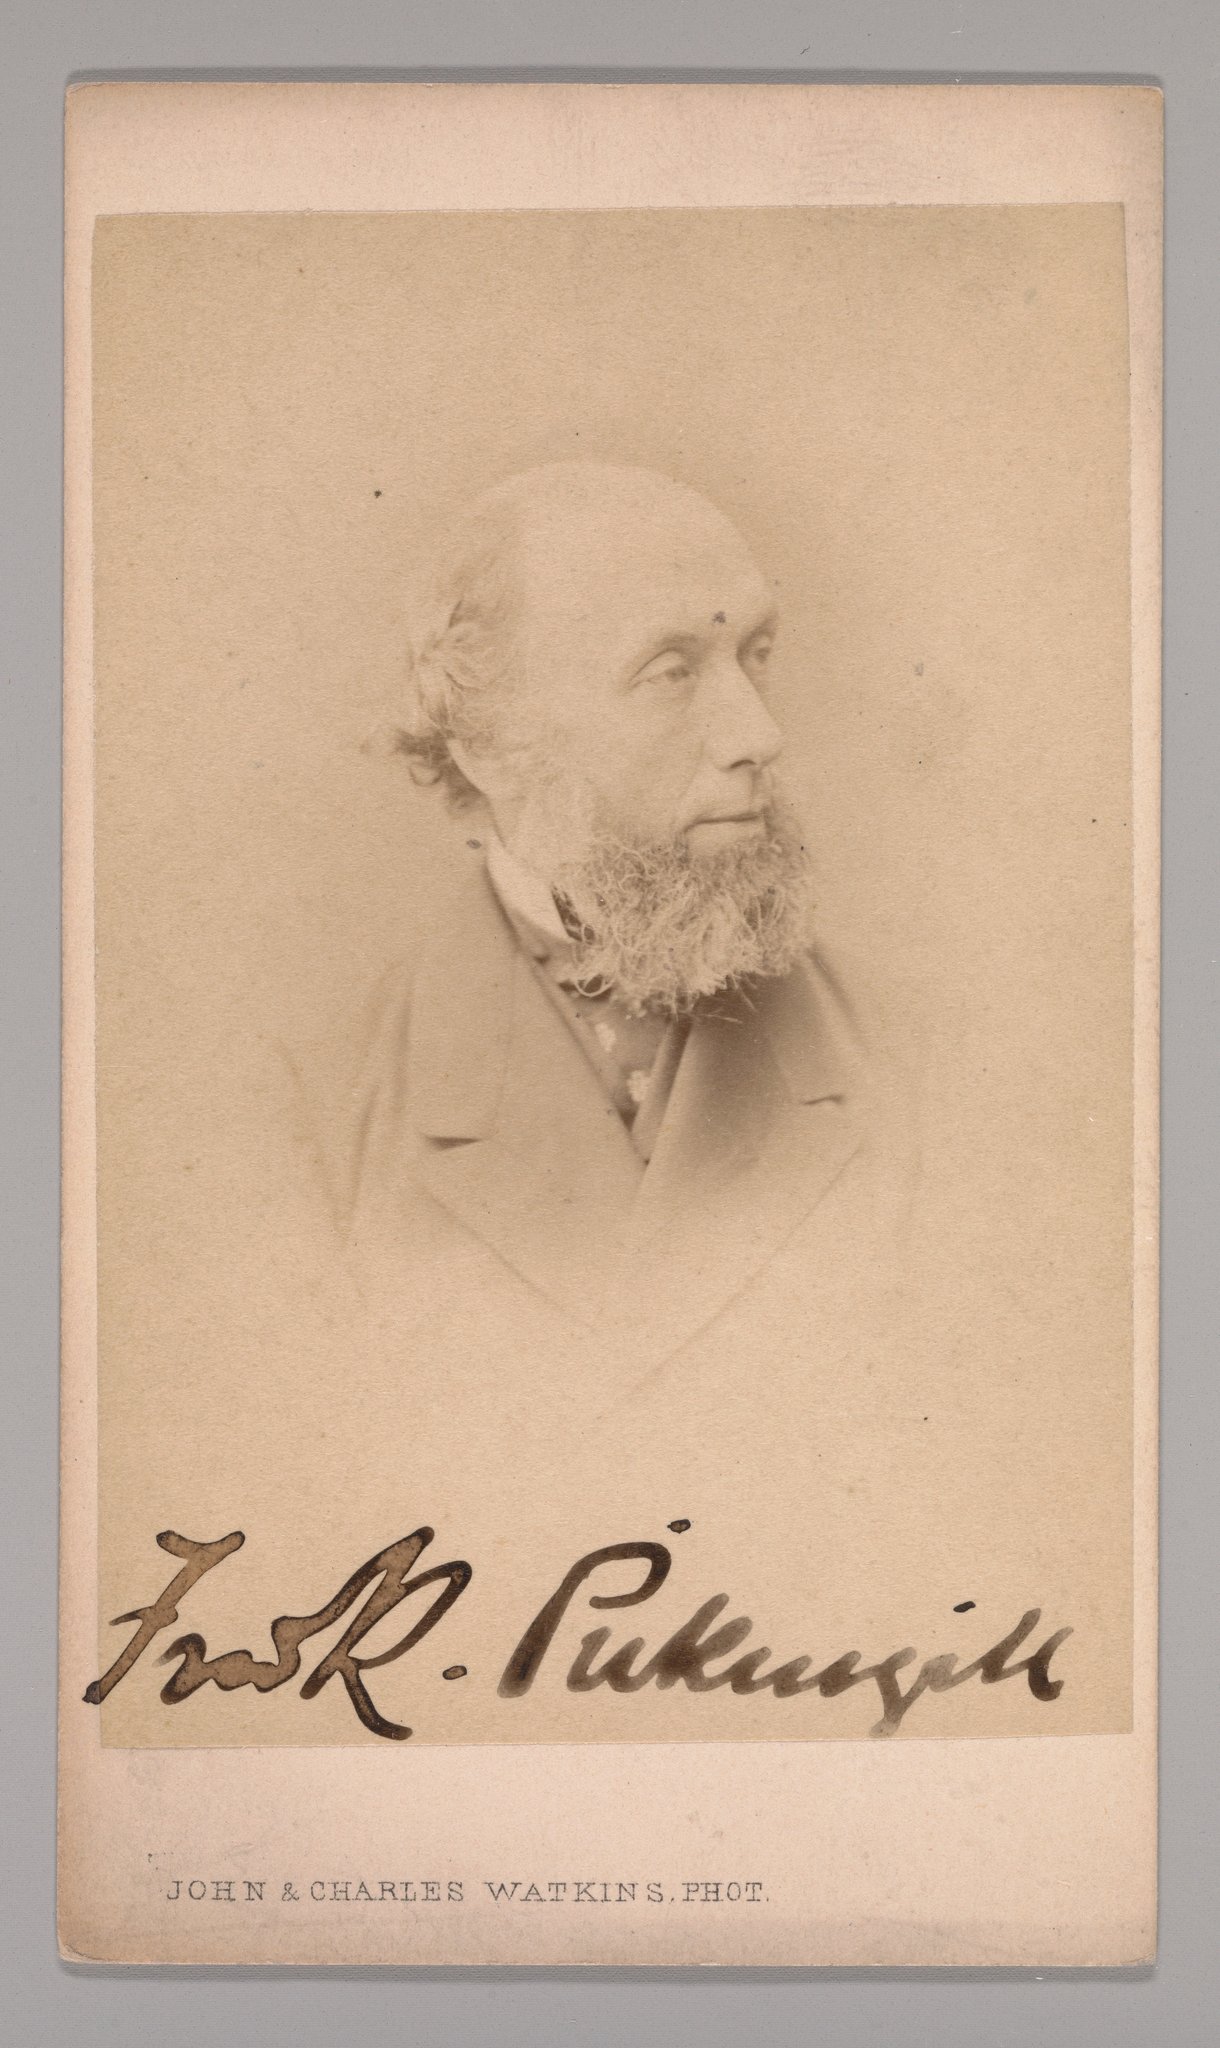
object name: carte de visite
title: [Frederick Richard Pickersgill]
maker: john and charles watkins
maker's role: photography studio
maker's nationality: british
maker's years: 1840-1875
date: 1860-1869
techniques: albumen silver print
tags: men,portraits